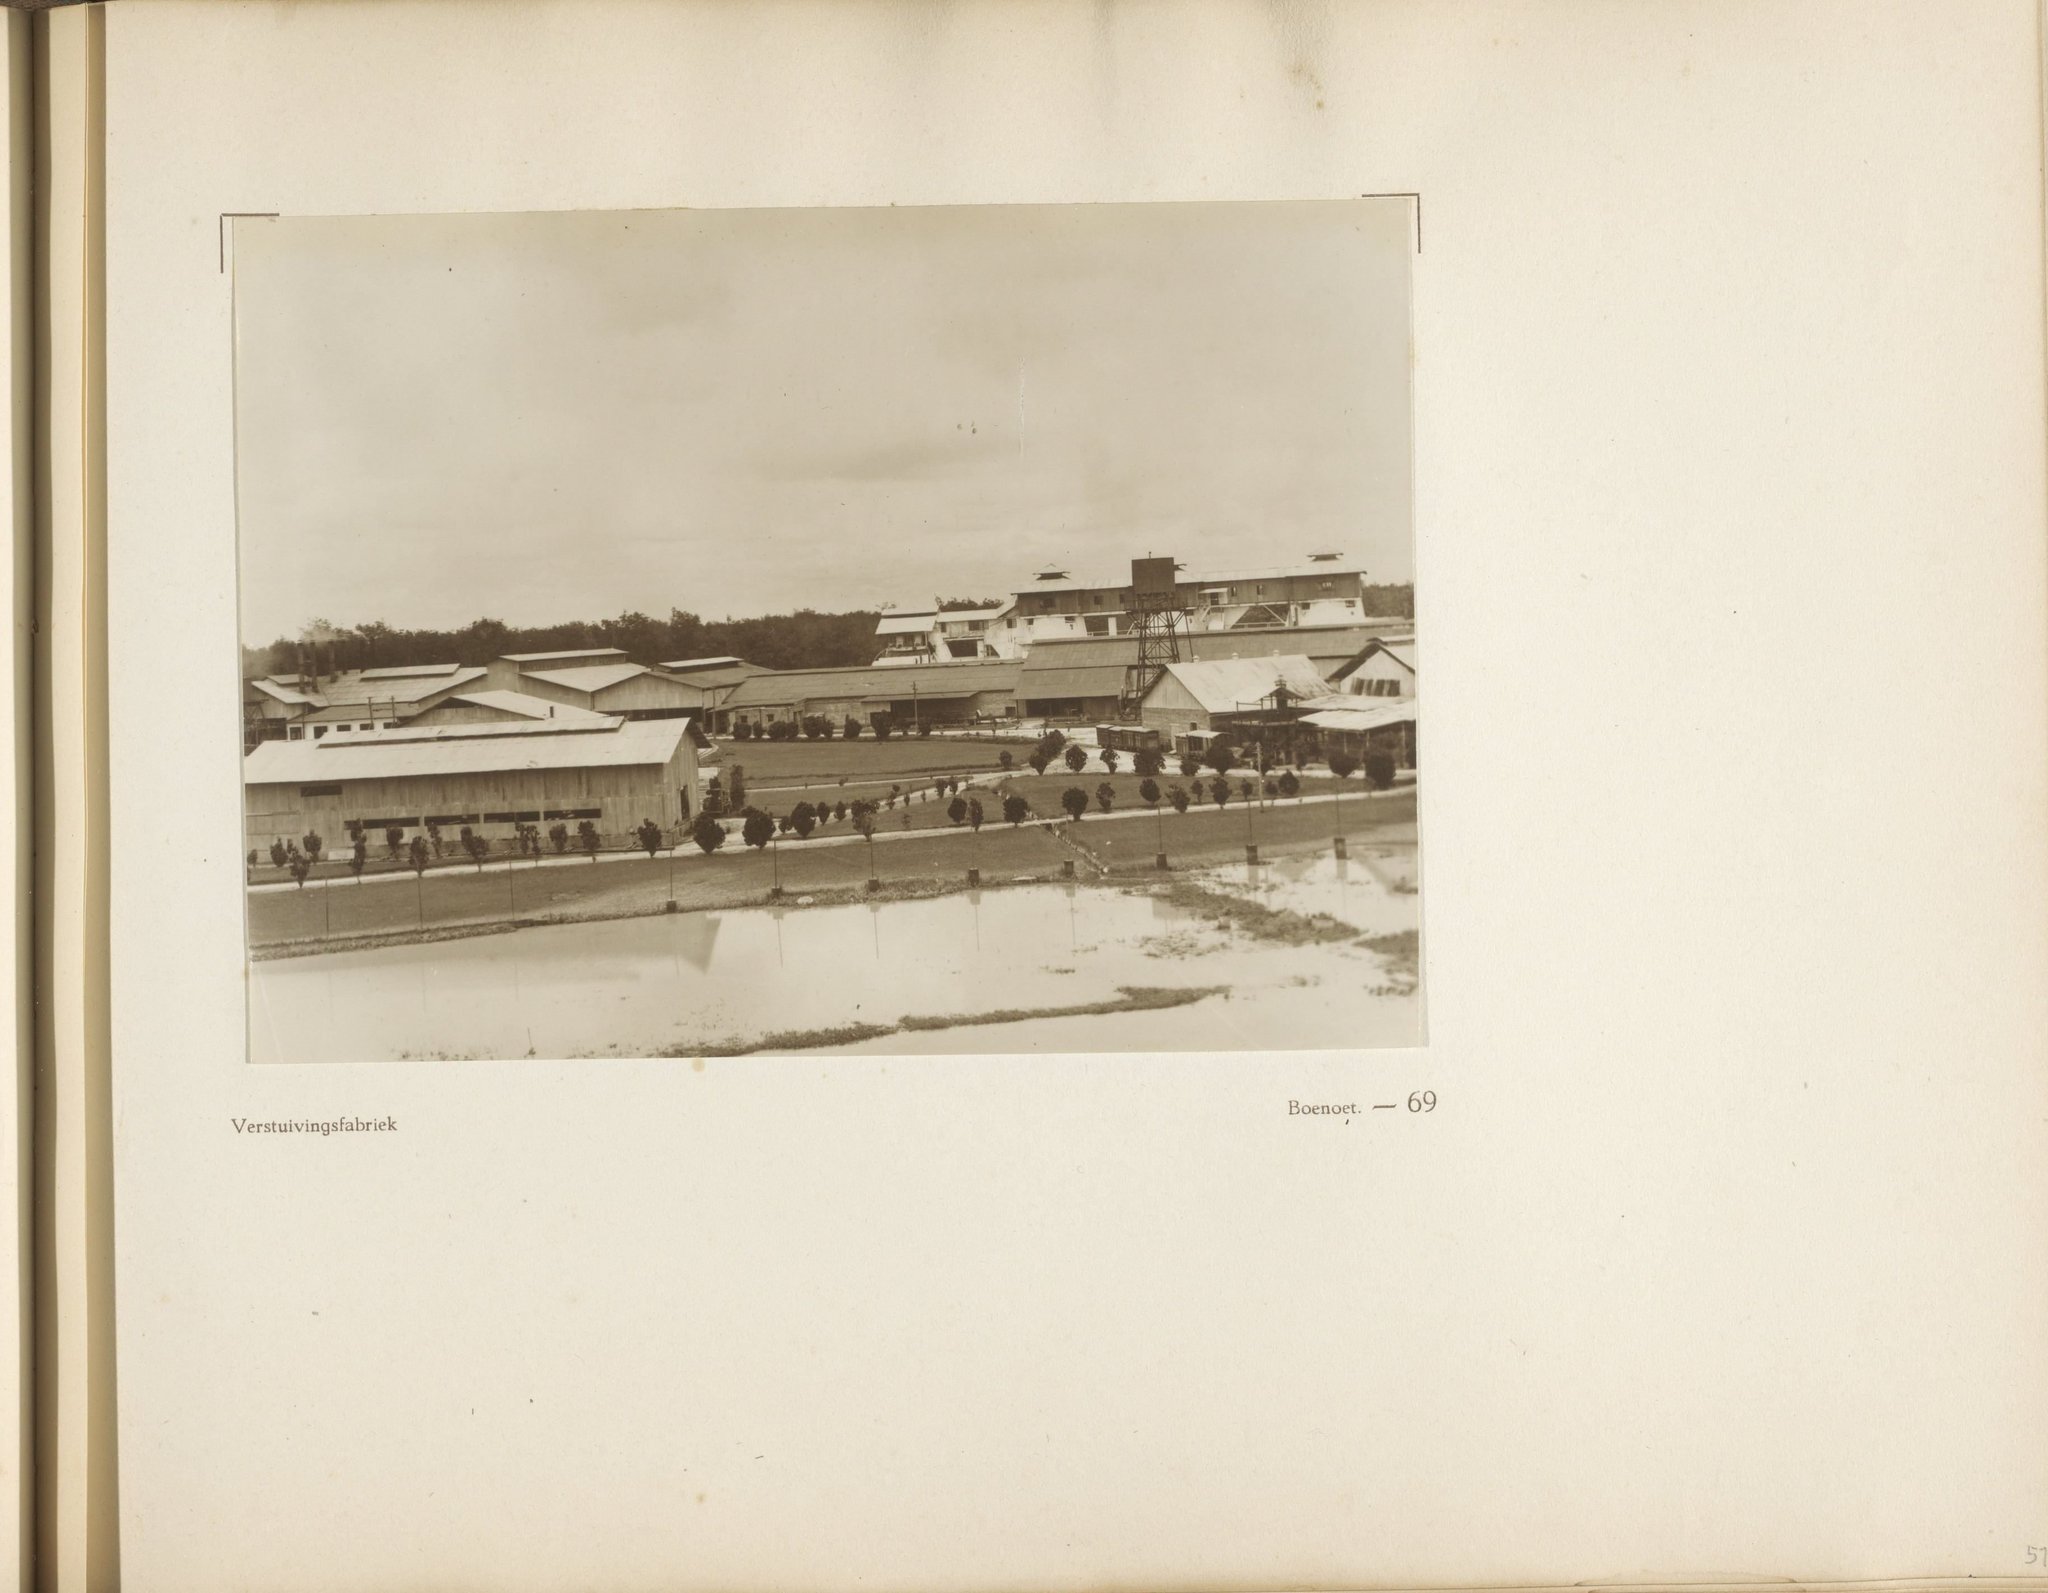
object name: photograph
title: Pagina 69 van fotoboek van de Algemeene Vereeniging van Rubberplanters ter Oostkust van Sumatra (A.V.R.O.S.)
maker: j.w. meyster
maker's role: fotograaf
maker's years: 1887-1945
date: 1924-1925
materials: paper, photographic support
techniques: printing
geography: sumatra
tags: factory-building, (non-fruit) products of plants or trees: rubber, sumatra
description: Boekpagina met een foto van het exterieur van een verstuivingsfabriek behorend bij een rubberfabriek van de Algemeene Vereeniging van Rubberplanters ter Oostkust van Sumatra (A.V.R.O.S.) te Boenoet. Onderdeel van een fotoboek van de Algemeene Vereeniging van Rubberplanters ter Oostkust van Sumatra (A.V.R.O.S.).